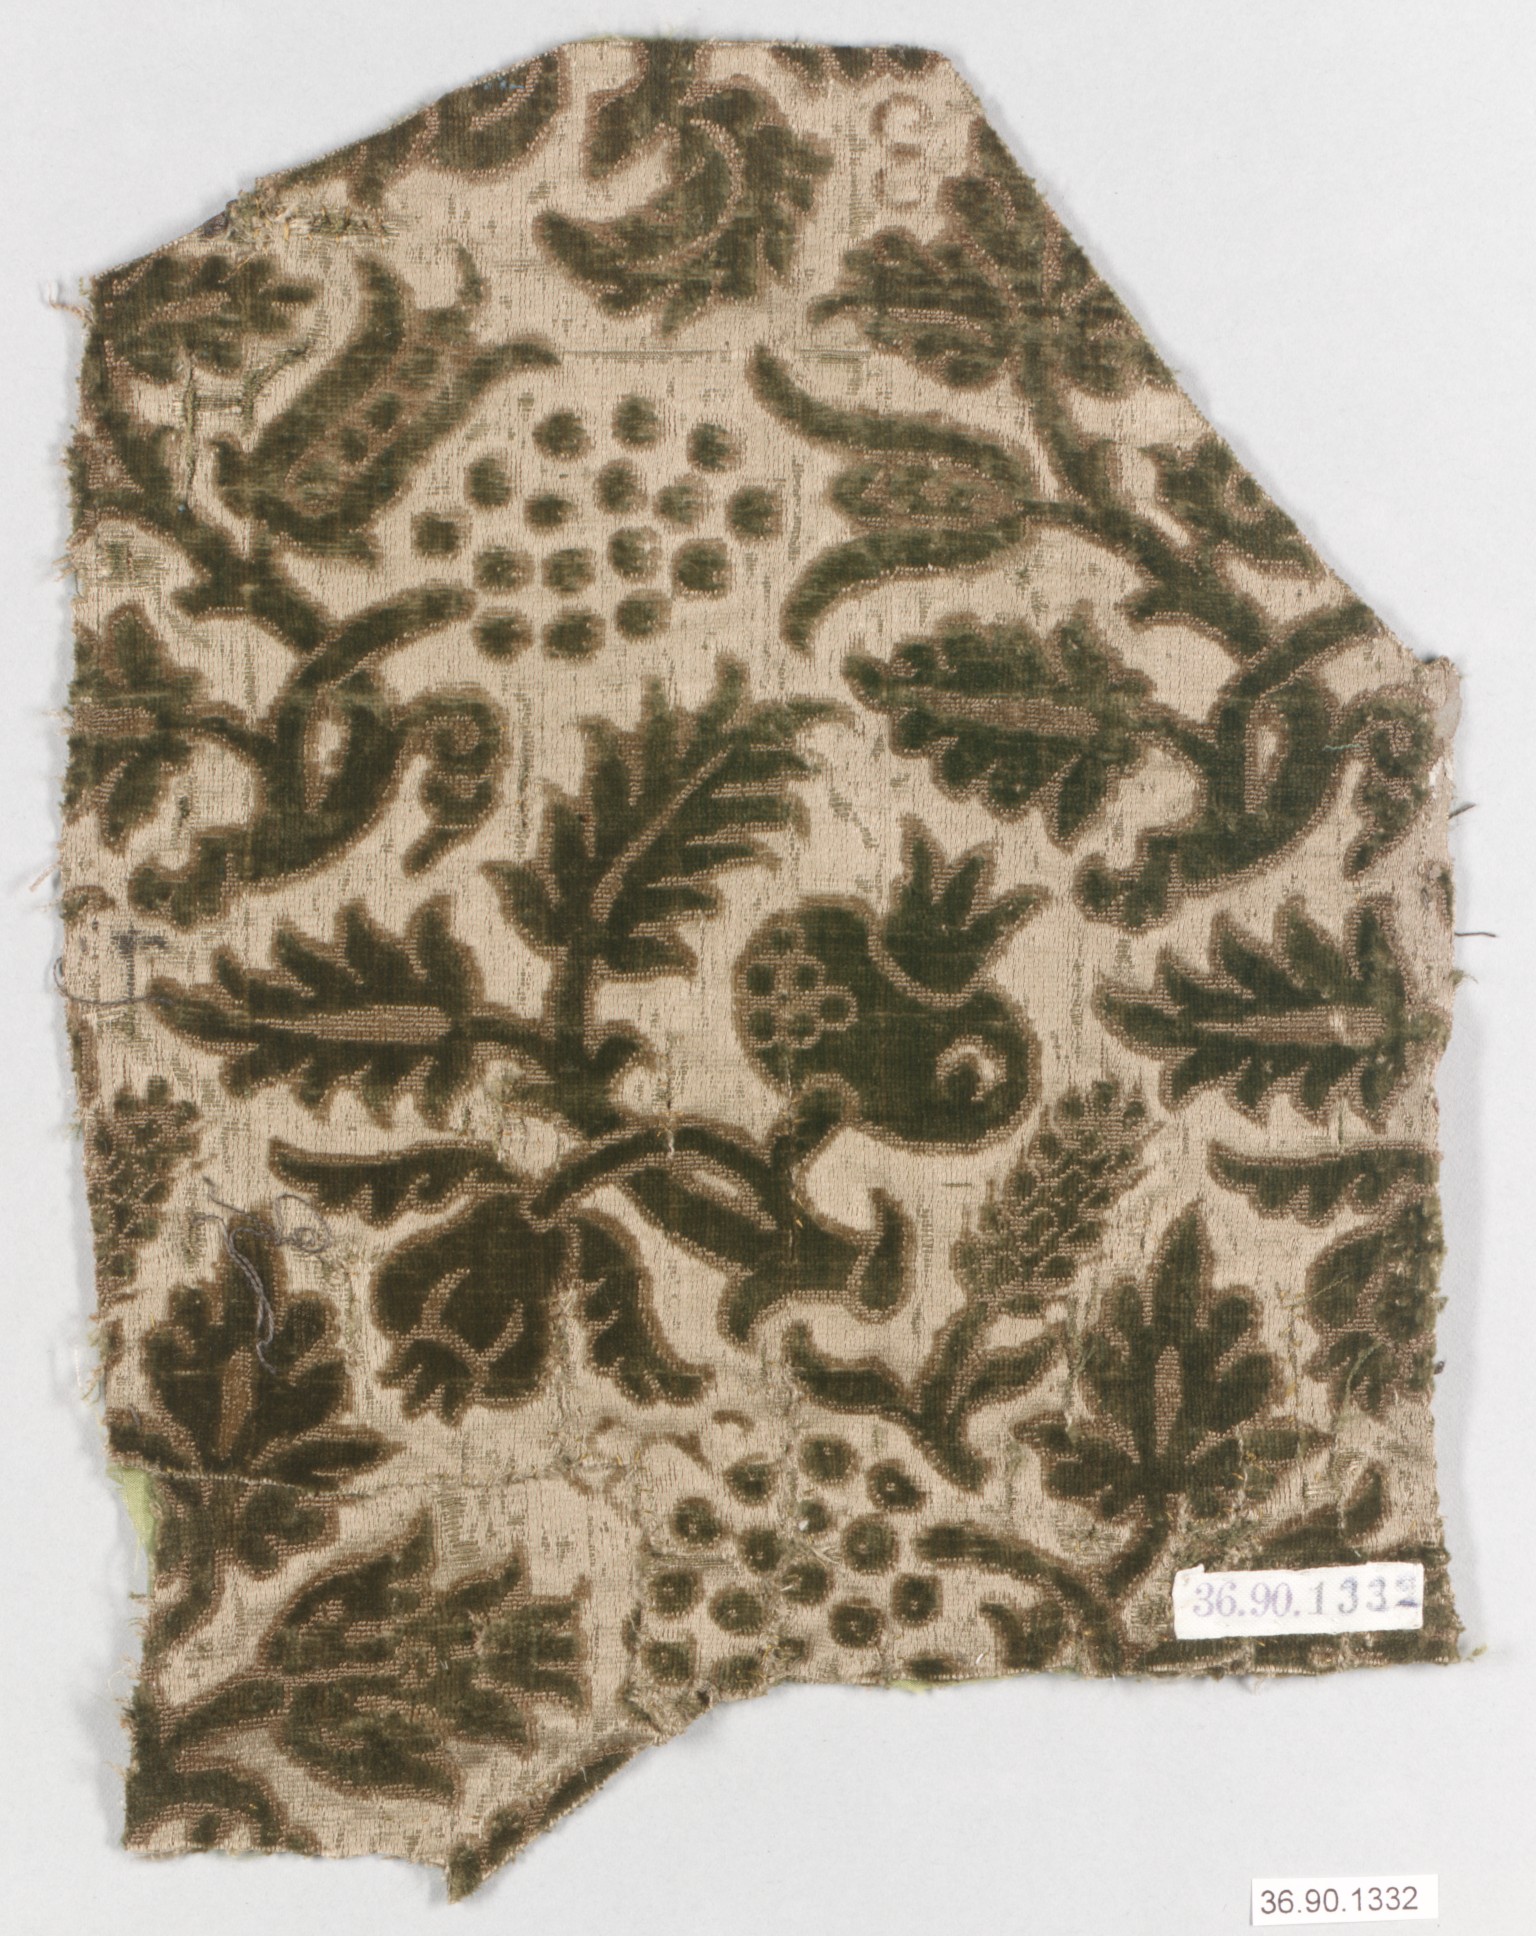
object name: piece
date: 1501-1700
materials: silk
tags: pomegranates,flowers,leaves